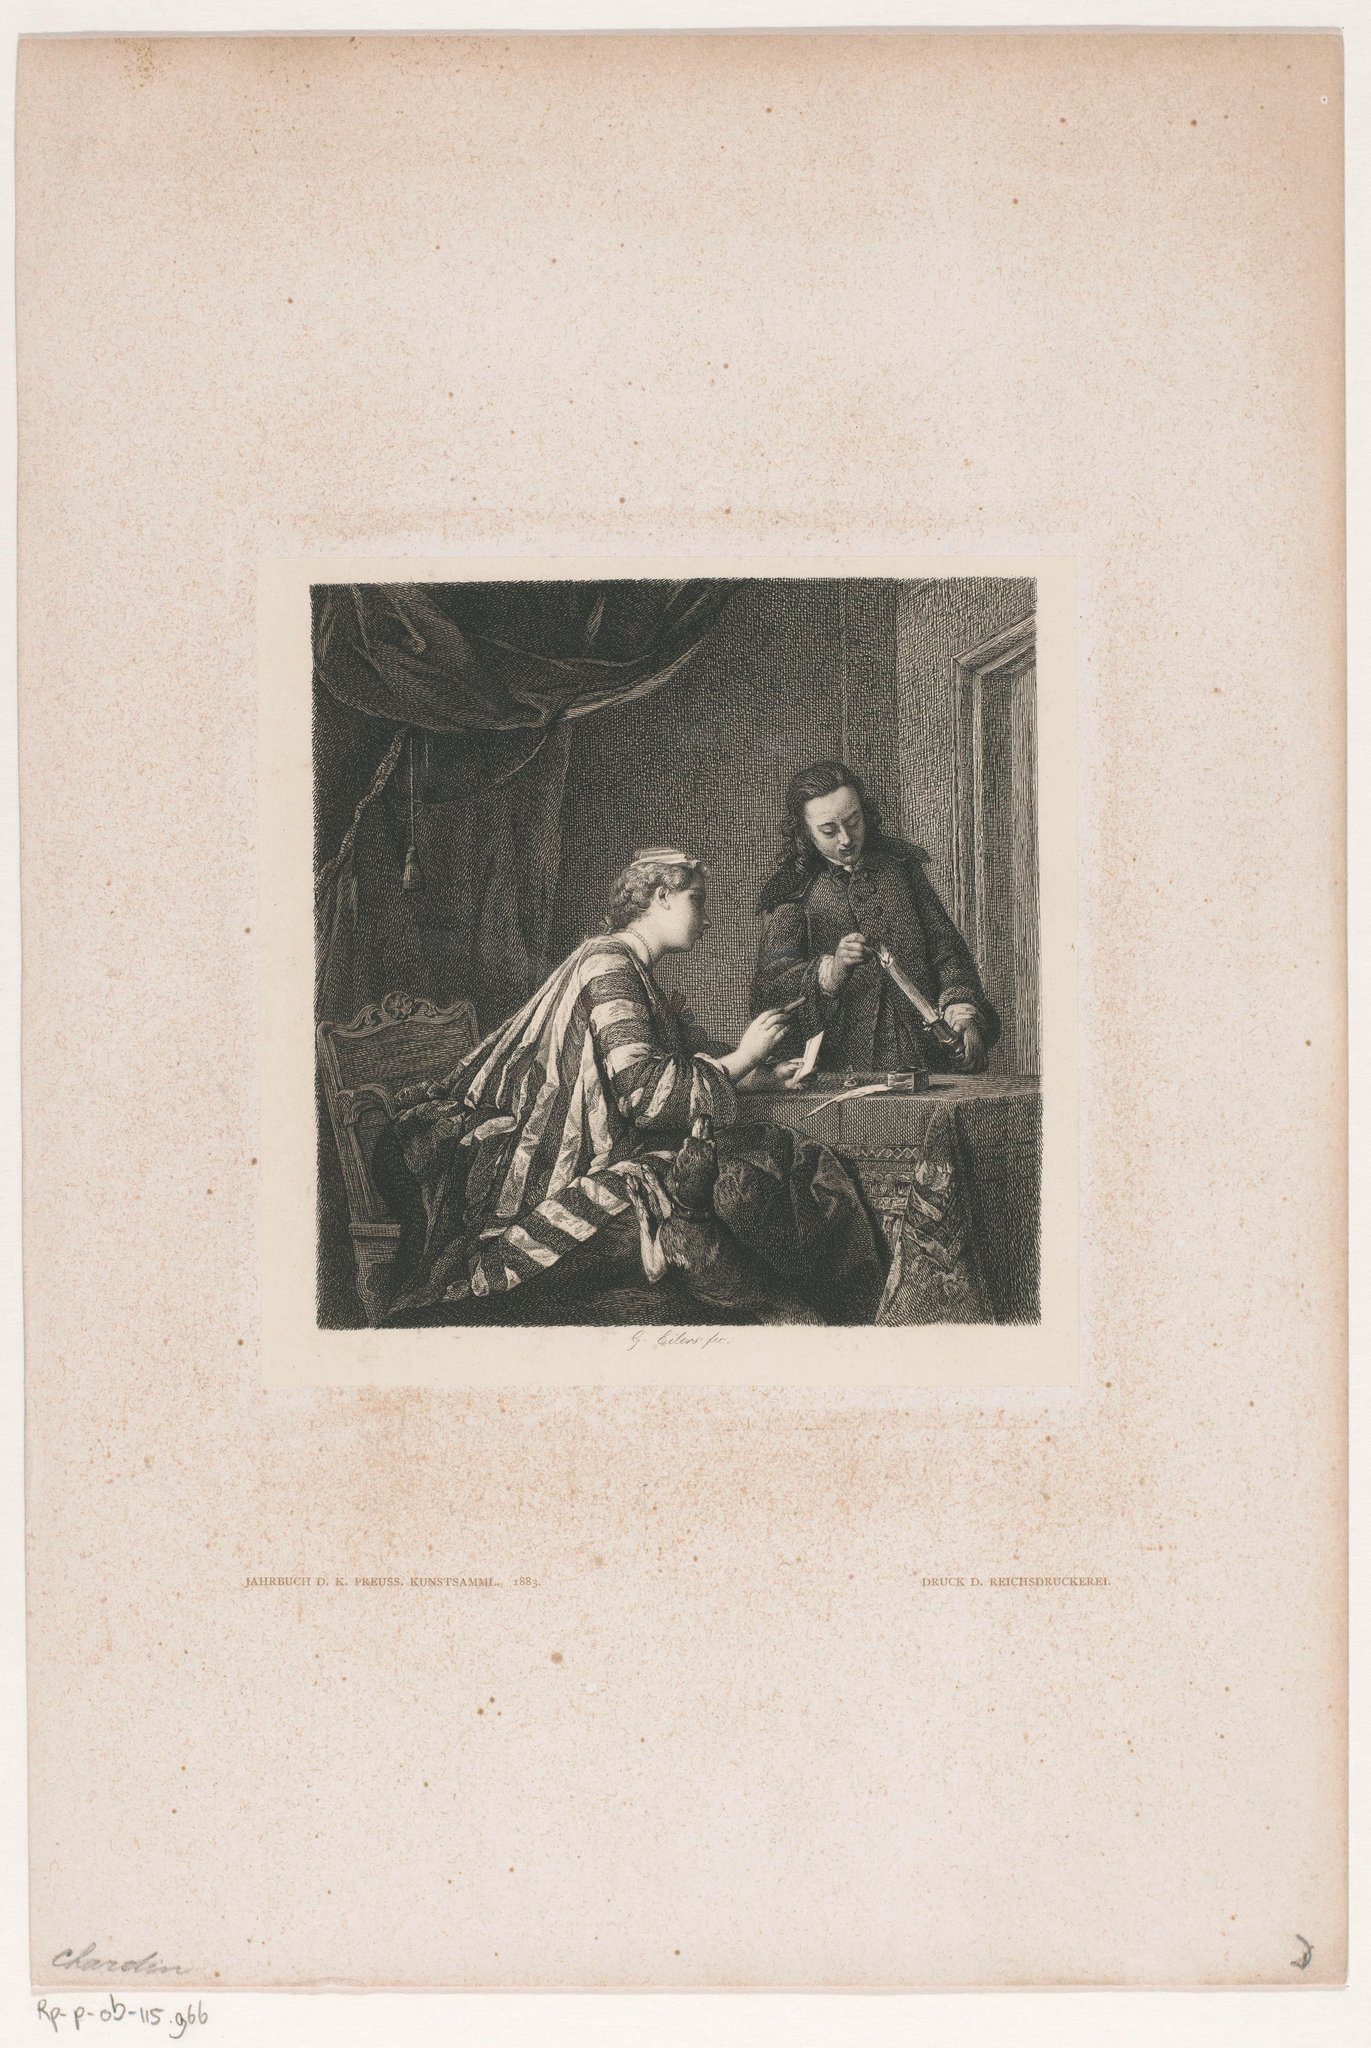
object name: print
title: Man en vrouw verzegelen een brief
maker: gustav eilers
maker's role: print maker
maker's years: 1834-1911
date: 1883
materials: paper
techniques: etching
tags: sealing wax, (feigned) picture curtain, seal, stamp, letter, envelope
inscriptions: collector's mark: Lugt 2228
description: Prent gebruikt voor: Jahrbuch der Königlich Preussischen Kunstsammlungen. Berlijn: Weidmannsche Buchhandlung, 1883.